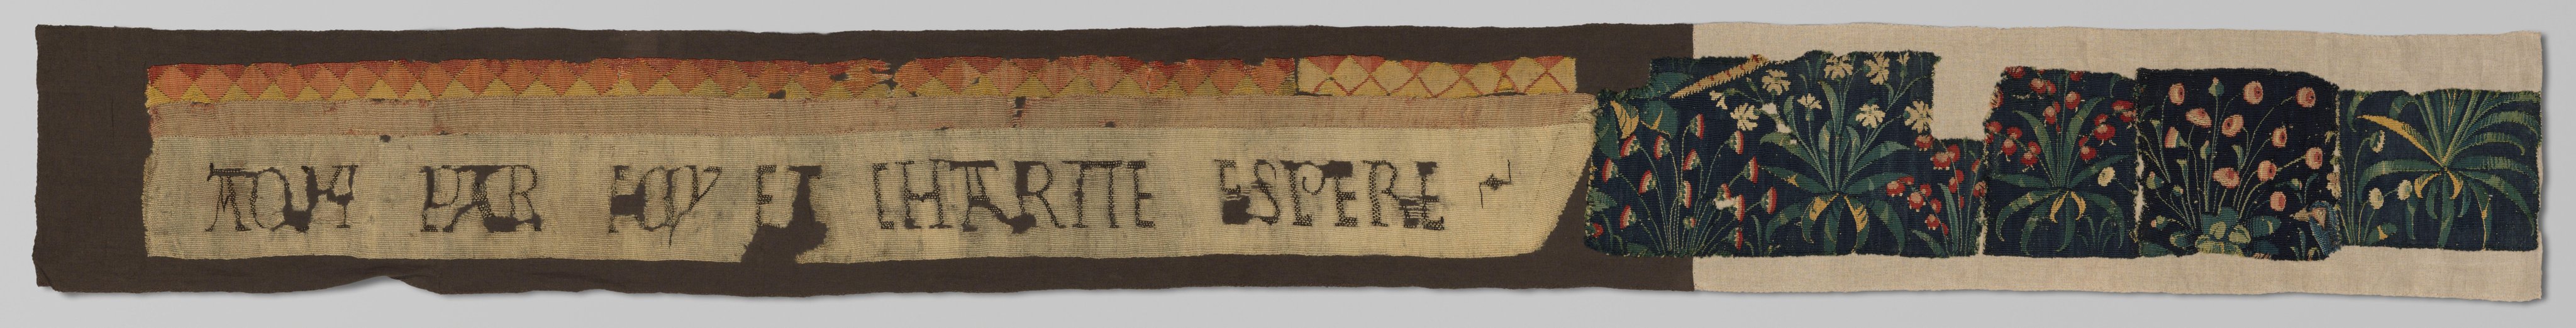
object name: tapestry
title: Fragment van een wandtapijt van een Millefleurs met de engelen van geloof en liefde die een armilliairsfeer vasthouden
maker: Anonymous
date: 1500-1525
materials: textile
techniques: tapestry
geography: southern netherlands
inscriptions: : ‘AMA’, : ‘[CR]E[D]E’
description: Fragment van een Mille-Fleurs wapentapijt van de familie Miron, lijfartsen van de Franse koningen. Op een blauw fond staan bloeiendeen in rozetvorm groeiende planten. Een hemelbol van aaneengeklonken vergulde banden, door een schuin gestelde dikke band met tekens omwonden en aan de polen met een ster versierd, wordt door twee zwevende engelen vastgehouden. De symmetrisch gestelde figuren hebben het lichaam en hoofd rechtop; de gebogen benen als in vliegende vaart achterwaarts gericht. De lange tunieken, links rood, rechts geel, vallen op en over een been en zijn tweemaal opgeschort. Achter hun middel waaien banderolles met CREDE en AMA. Bovenaan een deel van de rand met inschrift: A QUI PAR FOY ET CHARITE ESPERE (en bon endroit vers lui touruent les spheres).